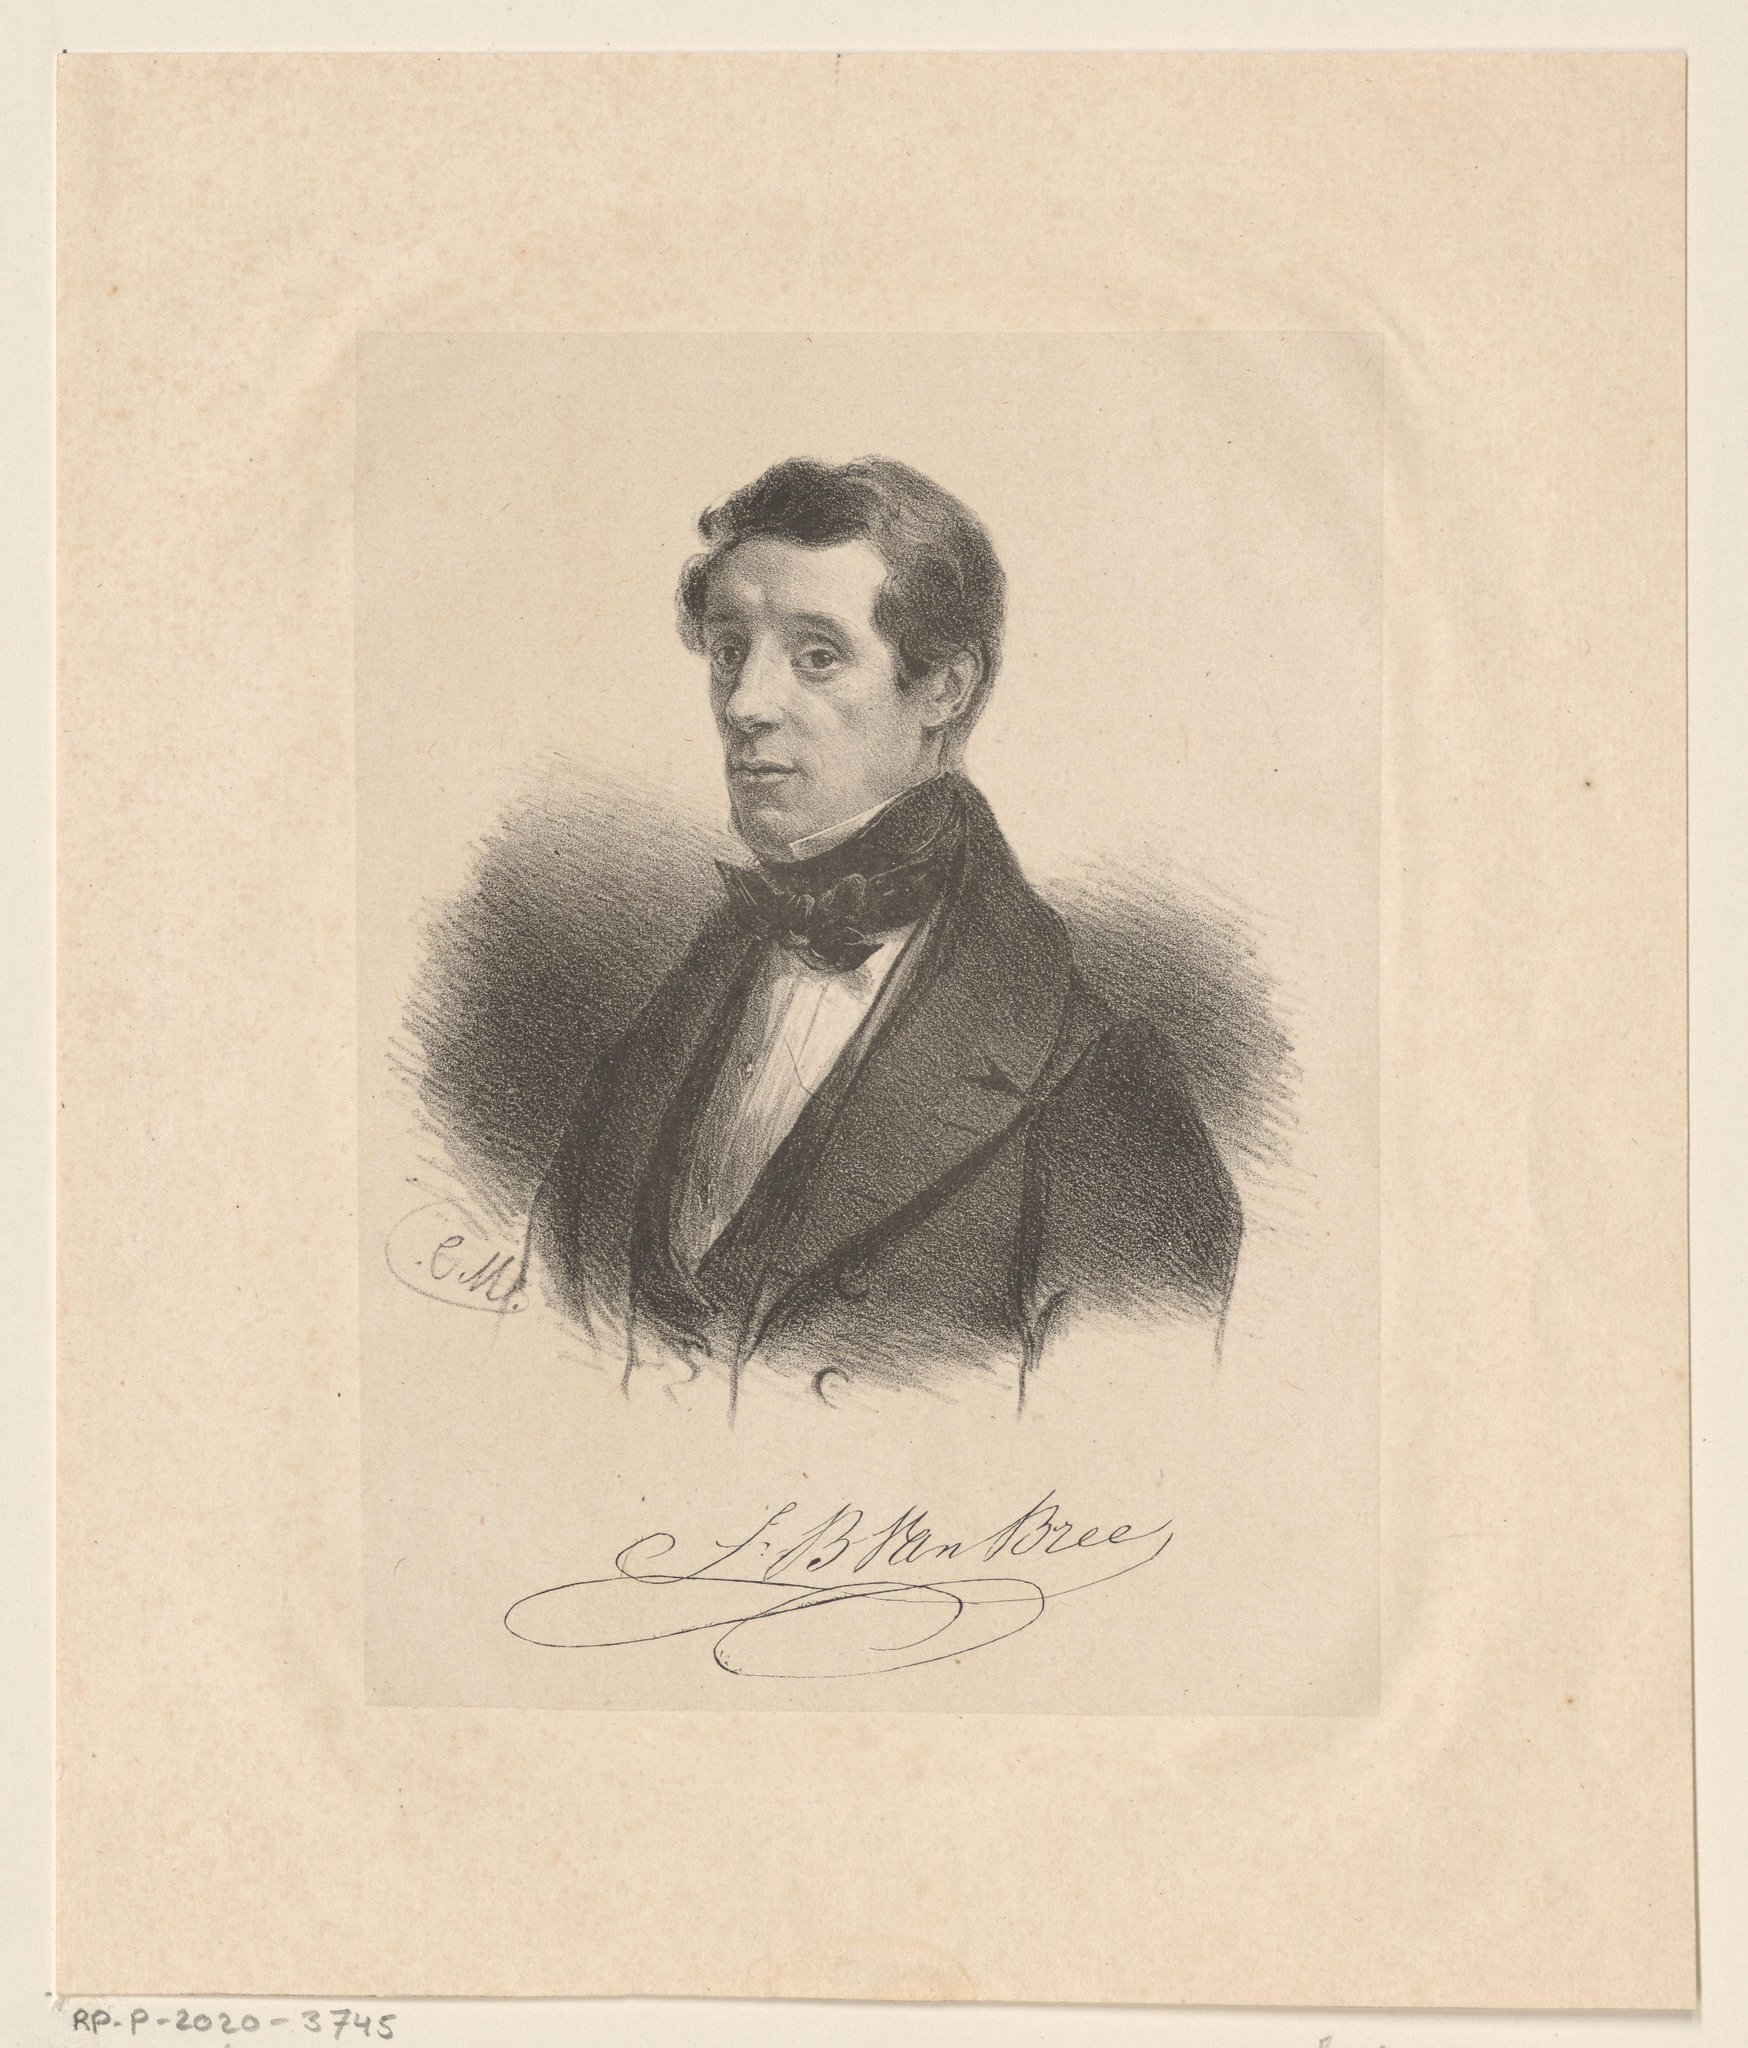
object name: print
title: Portret van Johannes Bernardus van Bree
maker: monogrammist cm (nederland)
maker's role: print maker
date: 1835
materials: paper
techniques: lithograph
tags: amsterdam, historical persons, portrait of composer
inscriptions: workshop stamp: ‘Theune & Co. Amsterdam’